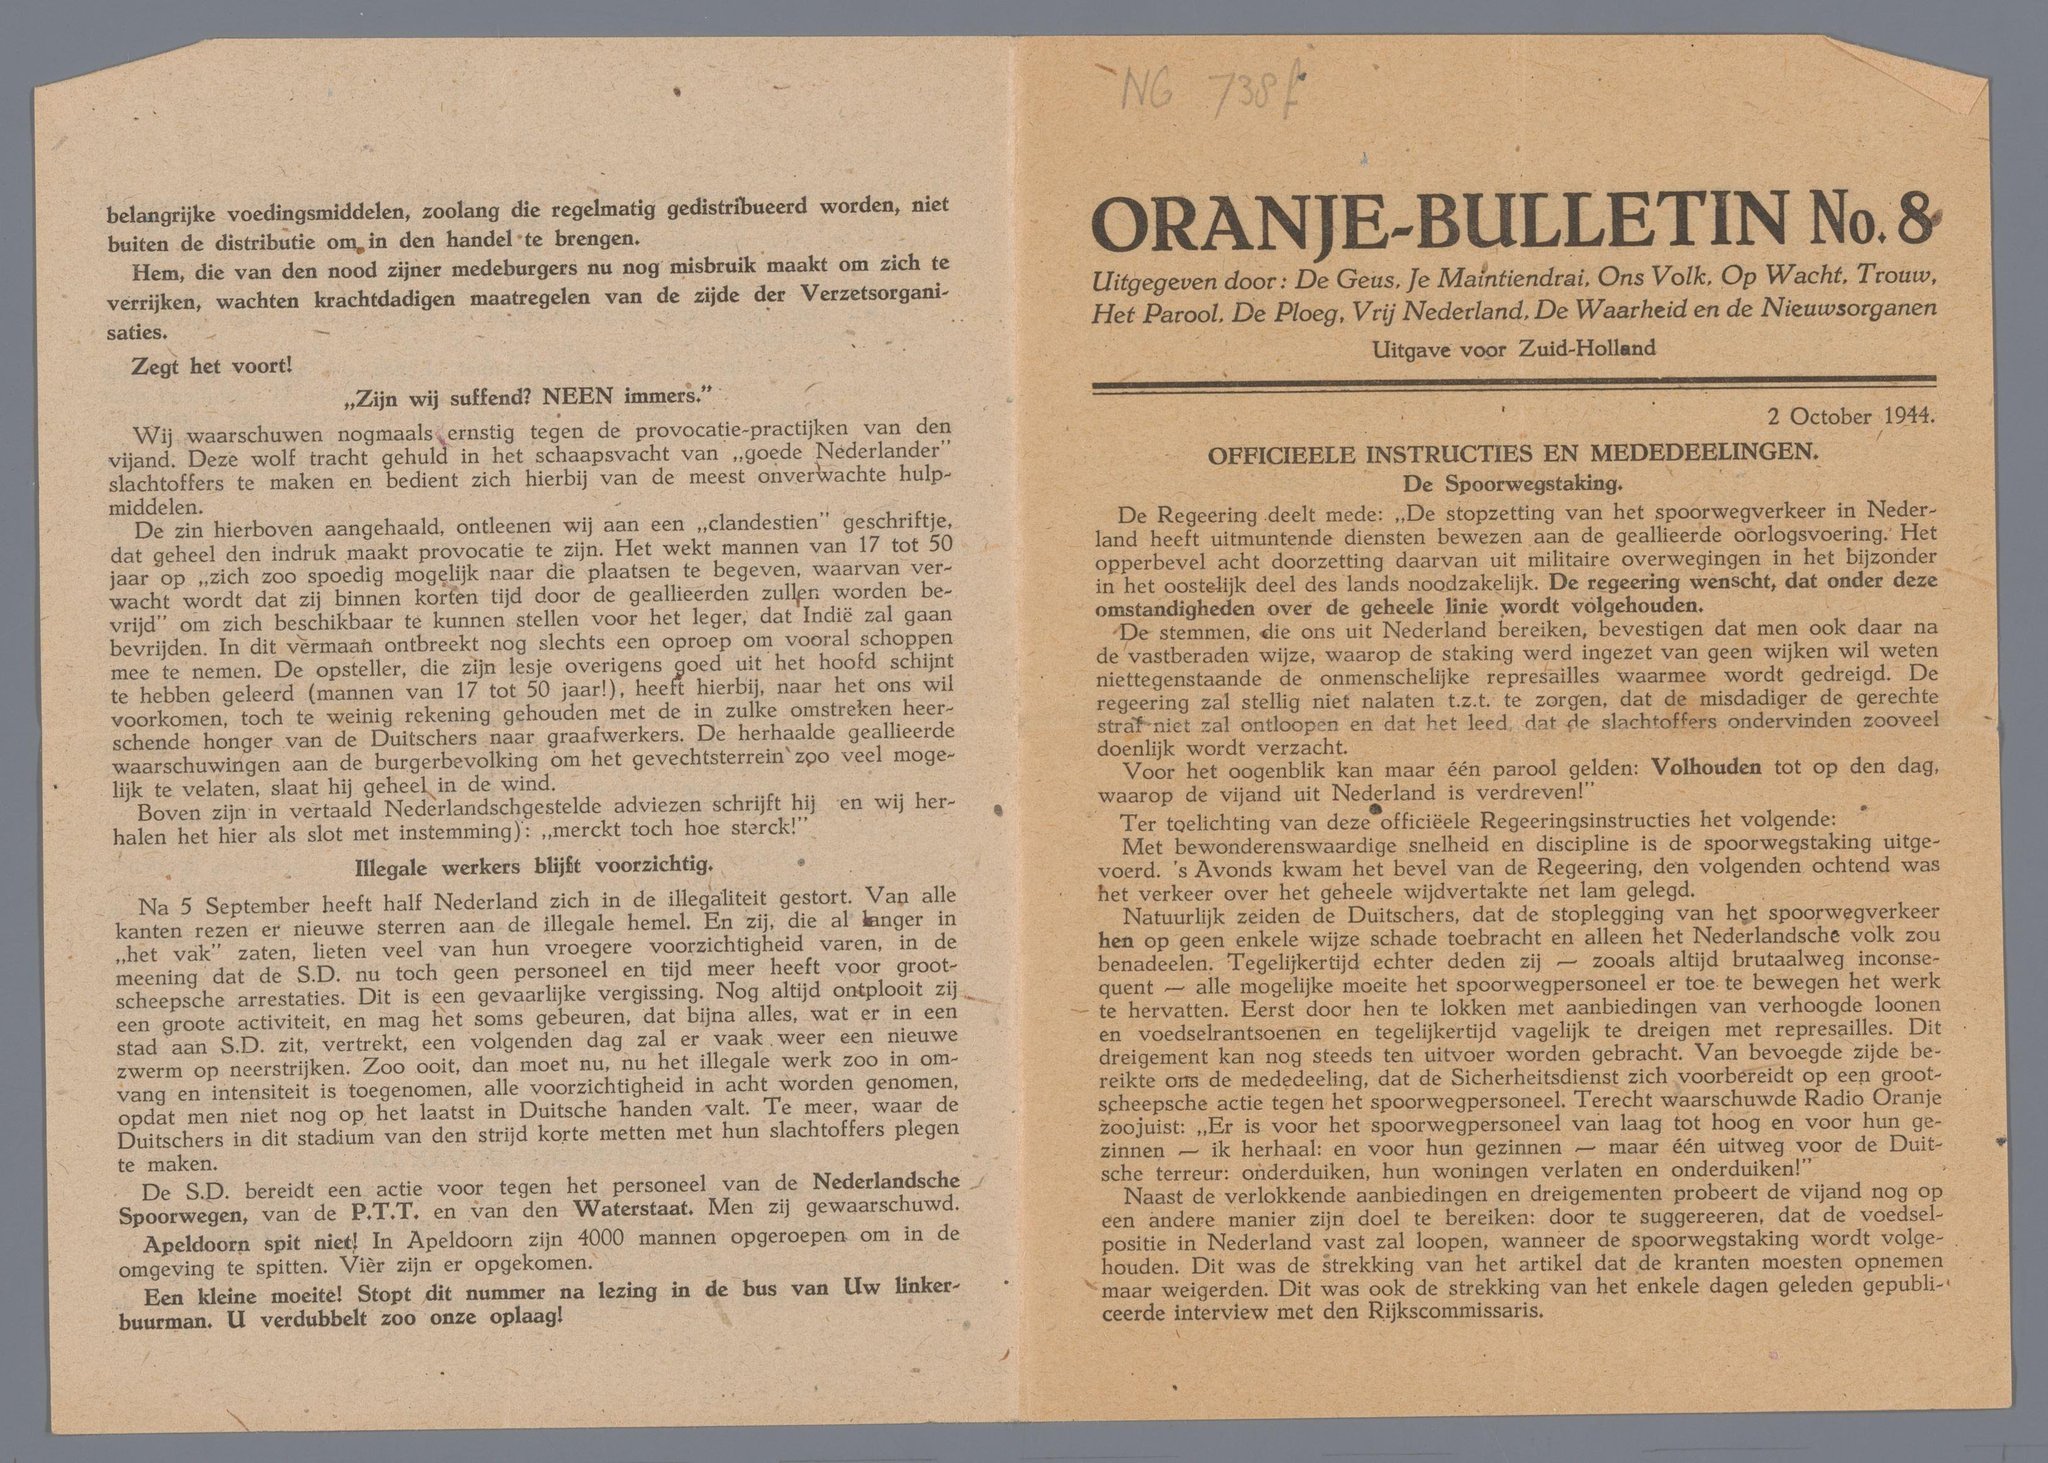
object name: newspaper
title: Oranje-Bulletin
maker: jm (uitgever)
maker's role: publisher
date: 1944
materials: paper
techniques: printing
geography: netherlands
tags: netherlands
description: Krant, illegale uitgave van samenwerkende verzetsorganisaties, Oranje-Bulletin nr. 8 voor Zuid-Holland; met officiele mededelingen, o.a. van de samenwerkende illegale organisaties, 4 pp.